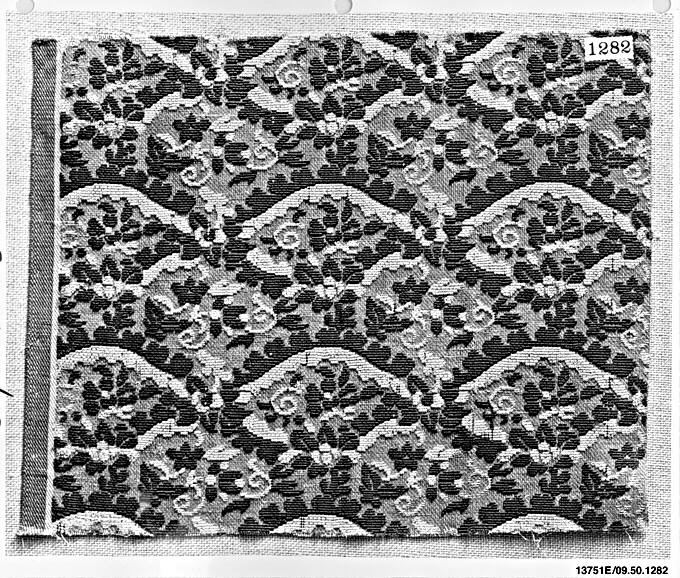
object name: piece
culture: chinese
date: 1801-1833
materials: silk, velvet